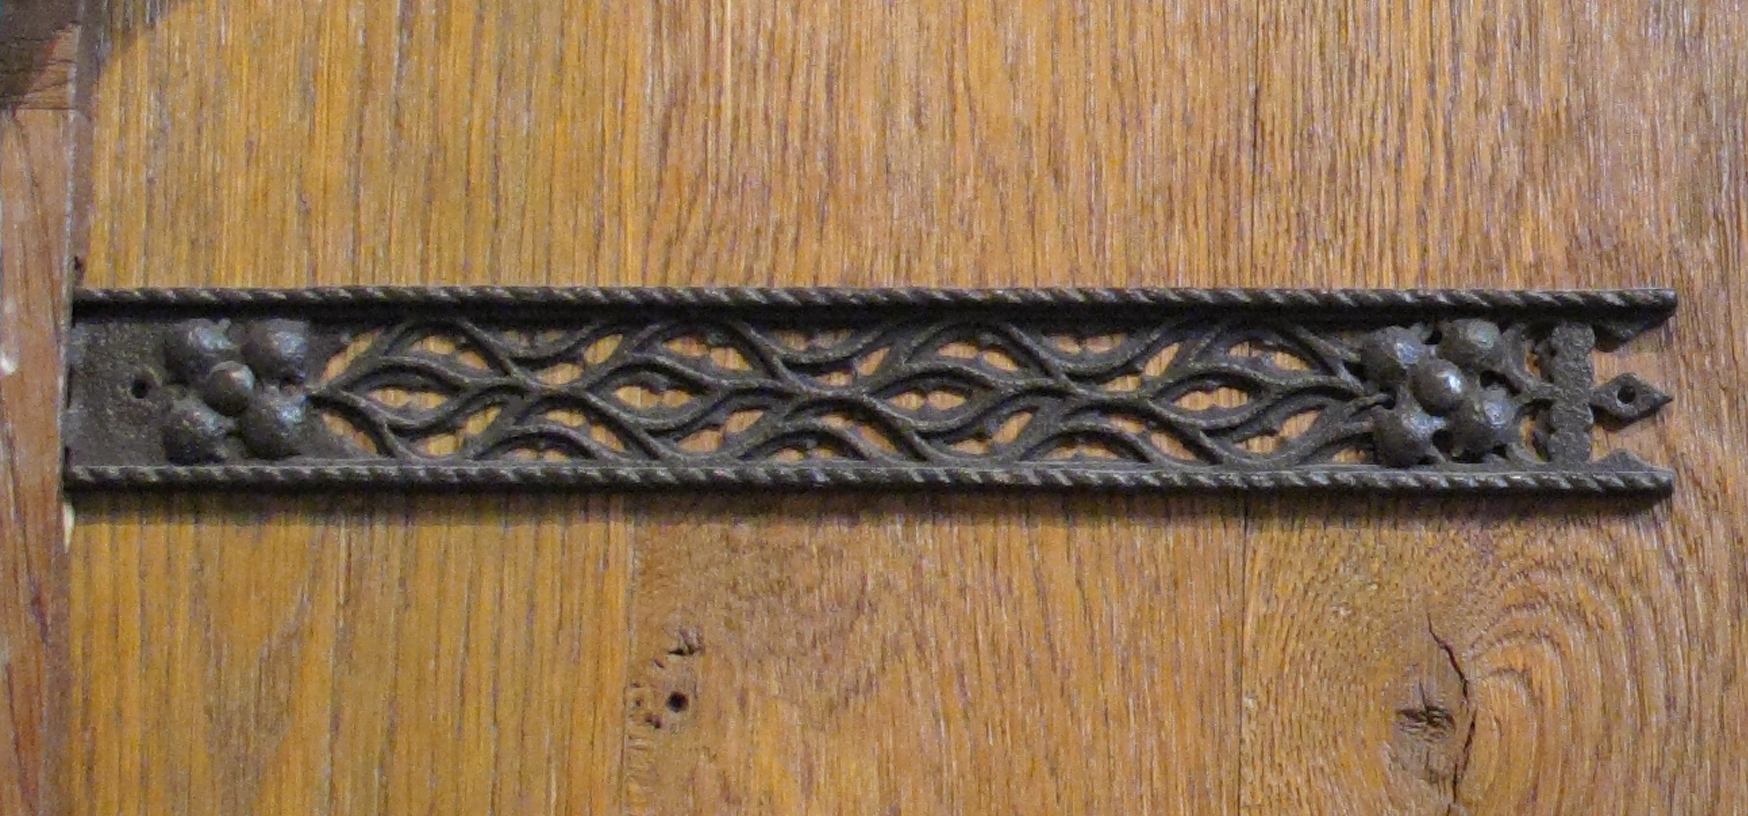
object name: hinge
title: Strap Hinge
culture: european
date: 1401-1600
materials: iron